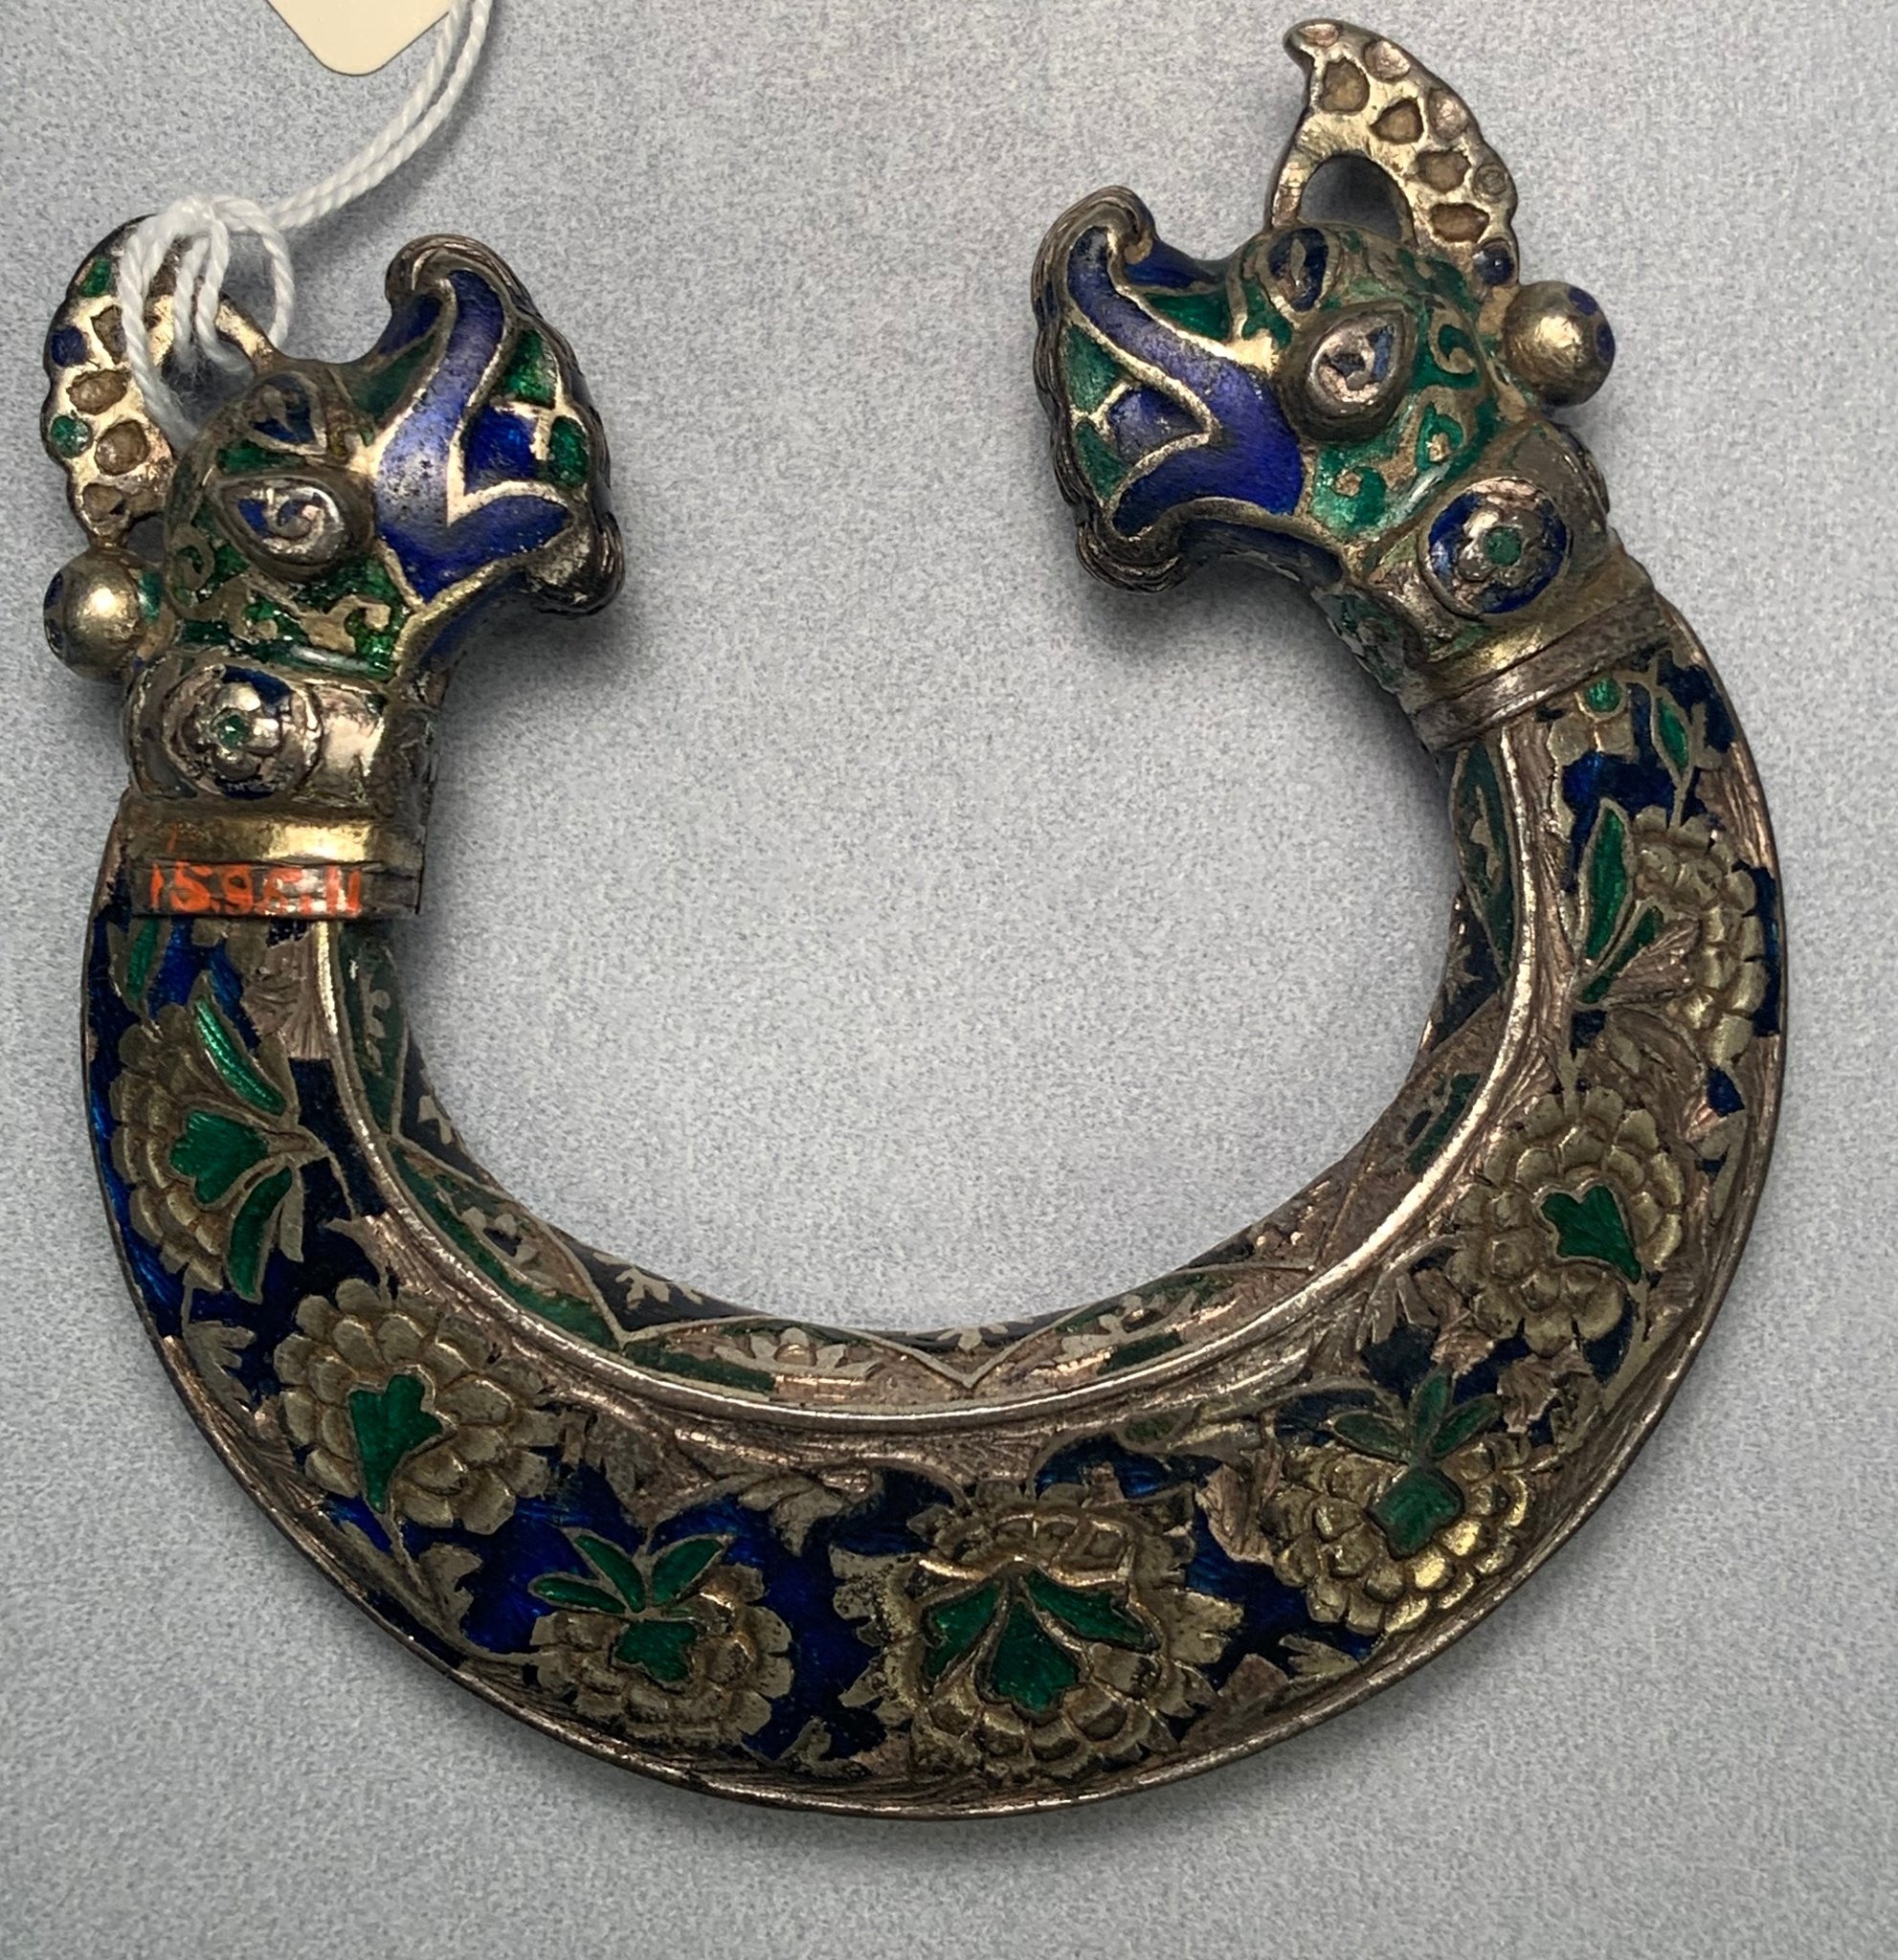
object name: bracelet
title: Bracelet (Kangan)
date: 1801-1900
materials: silver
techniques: enamel, gilding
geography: northern india